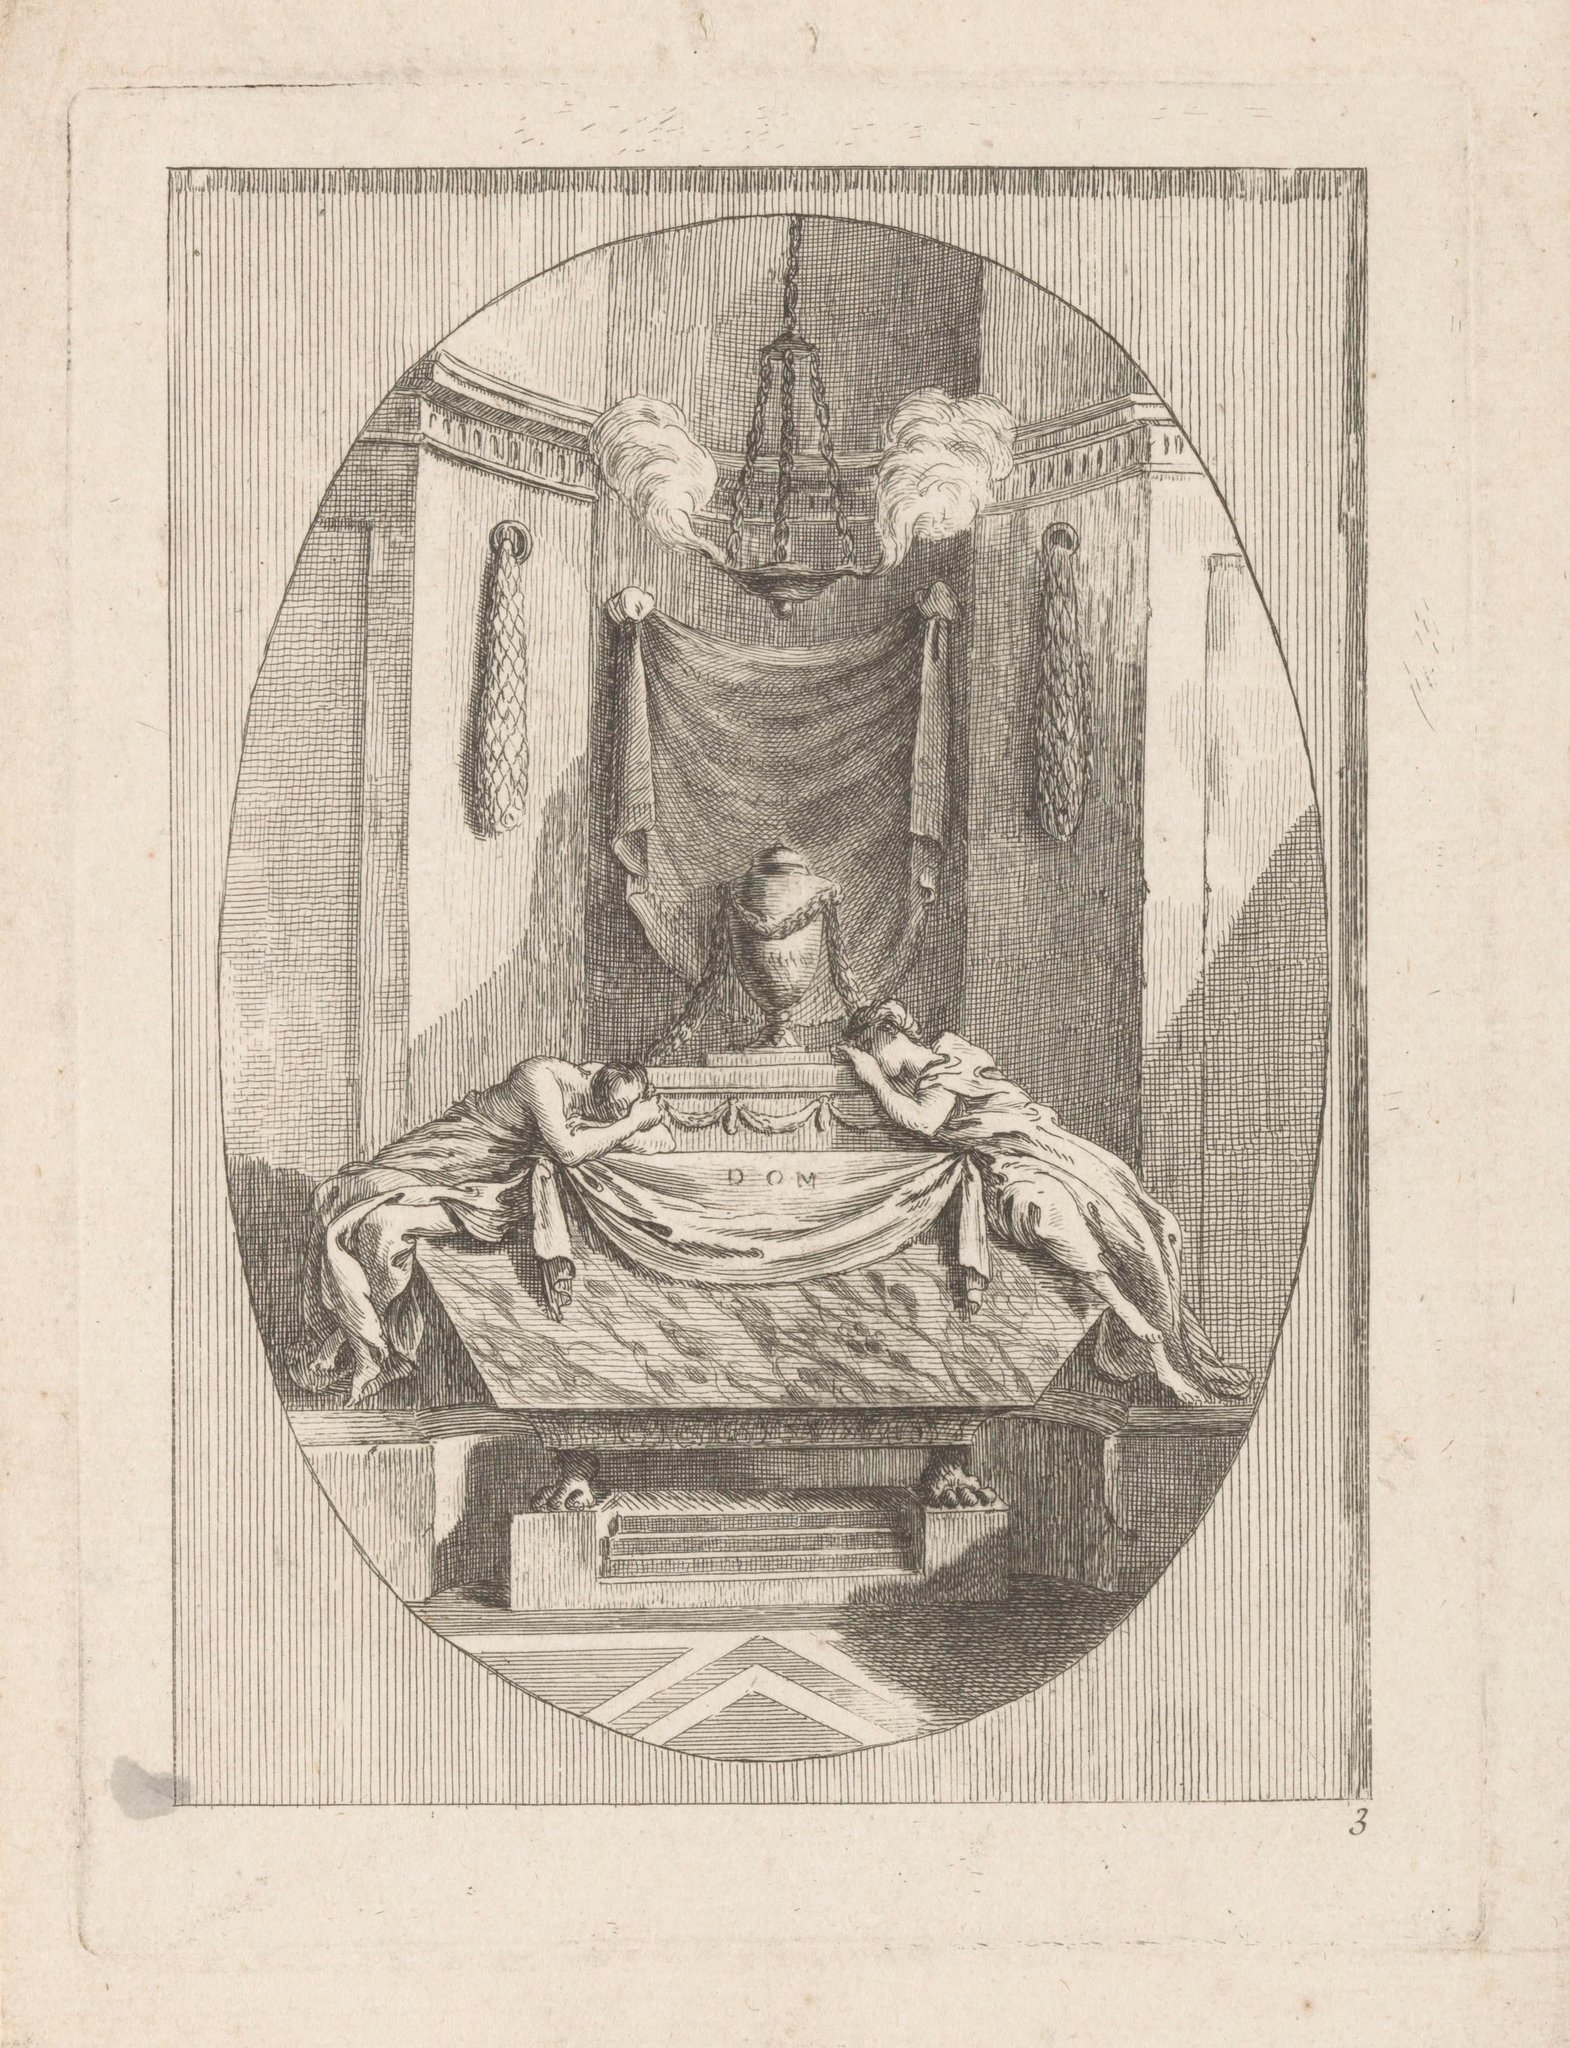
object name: ornament print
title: Livre De tombeaux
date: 1755-1782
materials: paper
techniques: etching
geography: paris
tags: incense-burner ~ scents, perfumes, façade (of house or building)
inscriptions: collector's mark: Lugt 2228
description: Een tombe op leeuwenpoten met een treurende man en vrouw, daarboven hangt een rookvat.